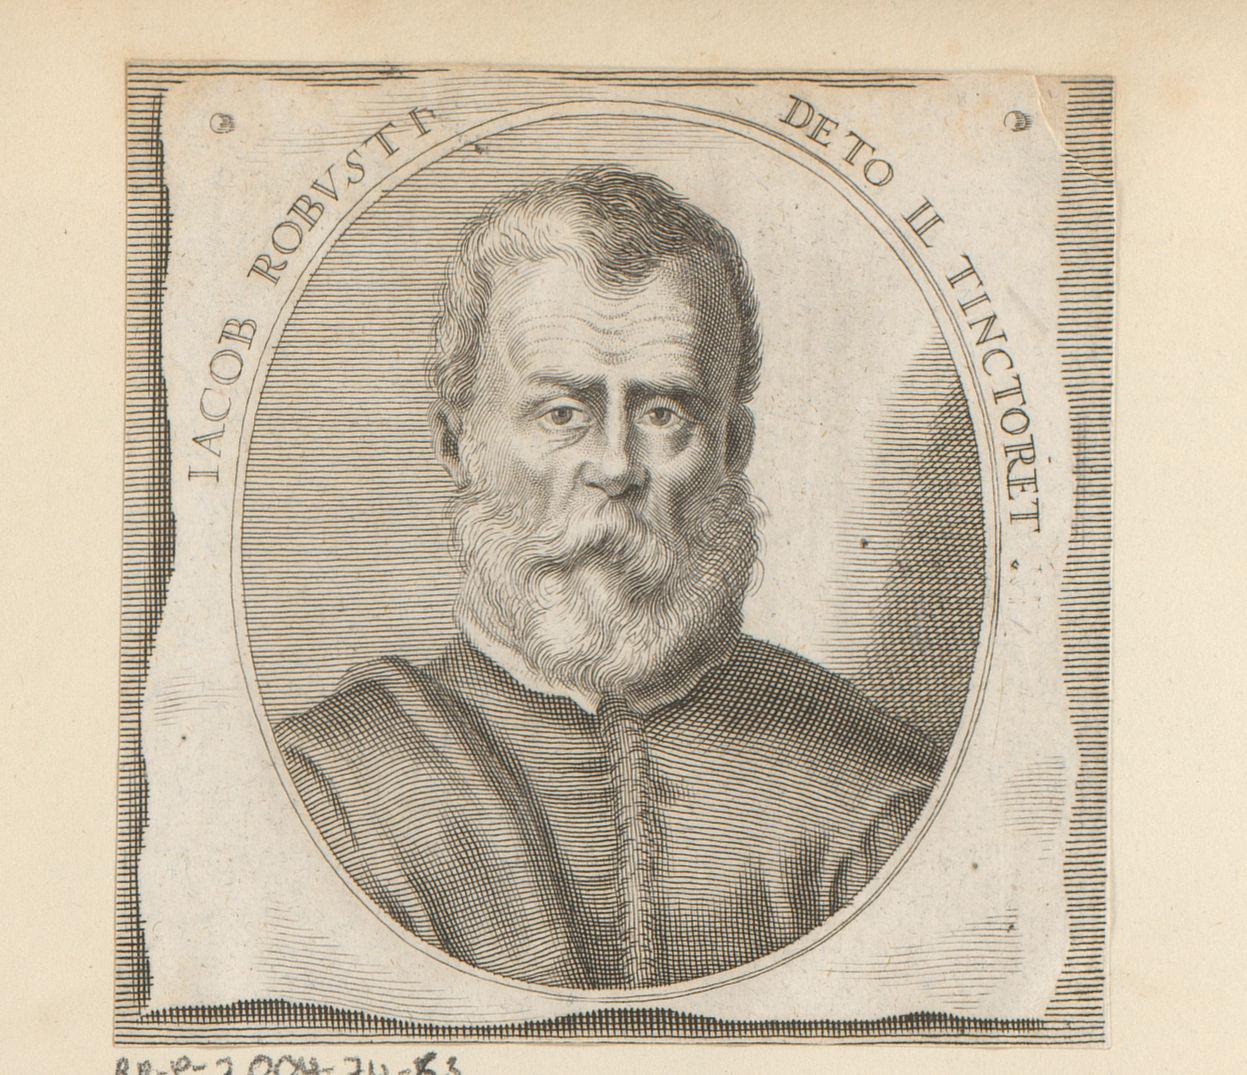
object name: print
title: Jacob Robust deto Il Tinctoret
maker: philipp kilian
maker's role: print maker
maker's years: 1628-1693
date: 1768-1775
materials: paper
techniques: engraving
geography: nuremberg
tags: venice, painter, print maker, draughtsman, jacopo tintoretto, historical persons, portrait, self-portrait of painter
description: Prent uit: Sandrart, Joachim von. Teutsche Academie der Bau- Bildhauer- und Maler-Kunst: worinn die Regeln und Lehrsätze dieser Künste gegeben. 14 dln. Neurenberg: erven Johann Andreas Endter, [1774], dl. 7, p. R. De samensteller heeft deze prent in het album geplakt als illustratie bij: Pilkington, Matthew en Johann Heinrich Füssli. A dictionary of painters, from the revival of the art to the present period. 4 dln. Londen: John Crowder, 1805, dl. 3, p. 456.